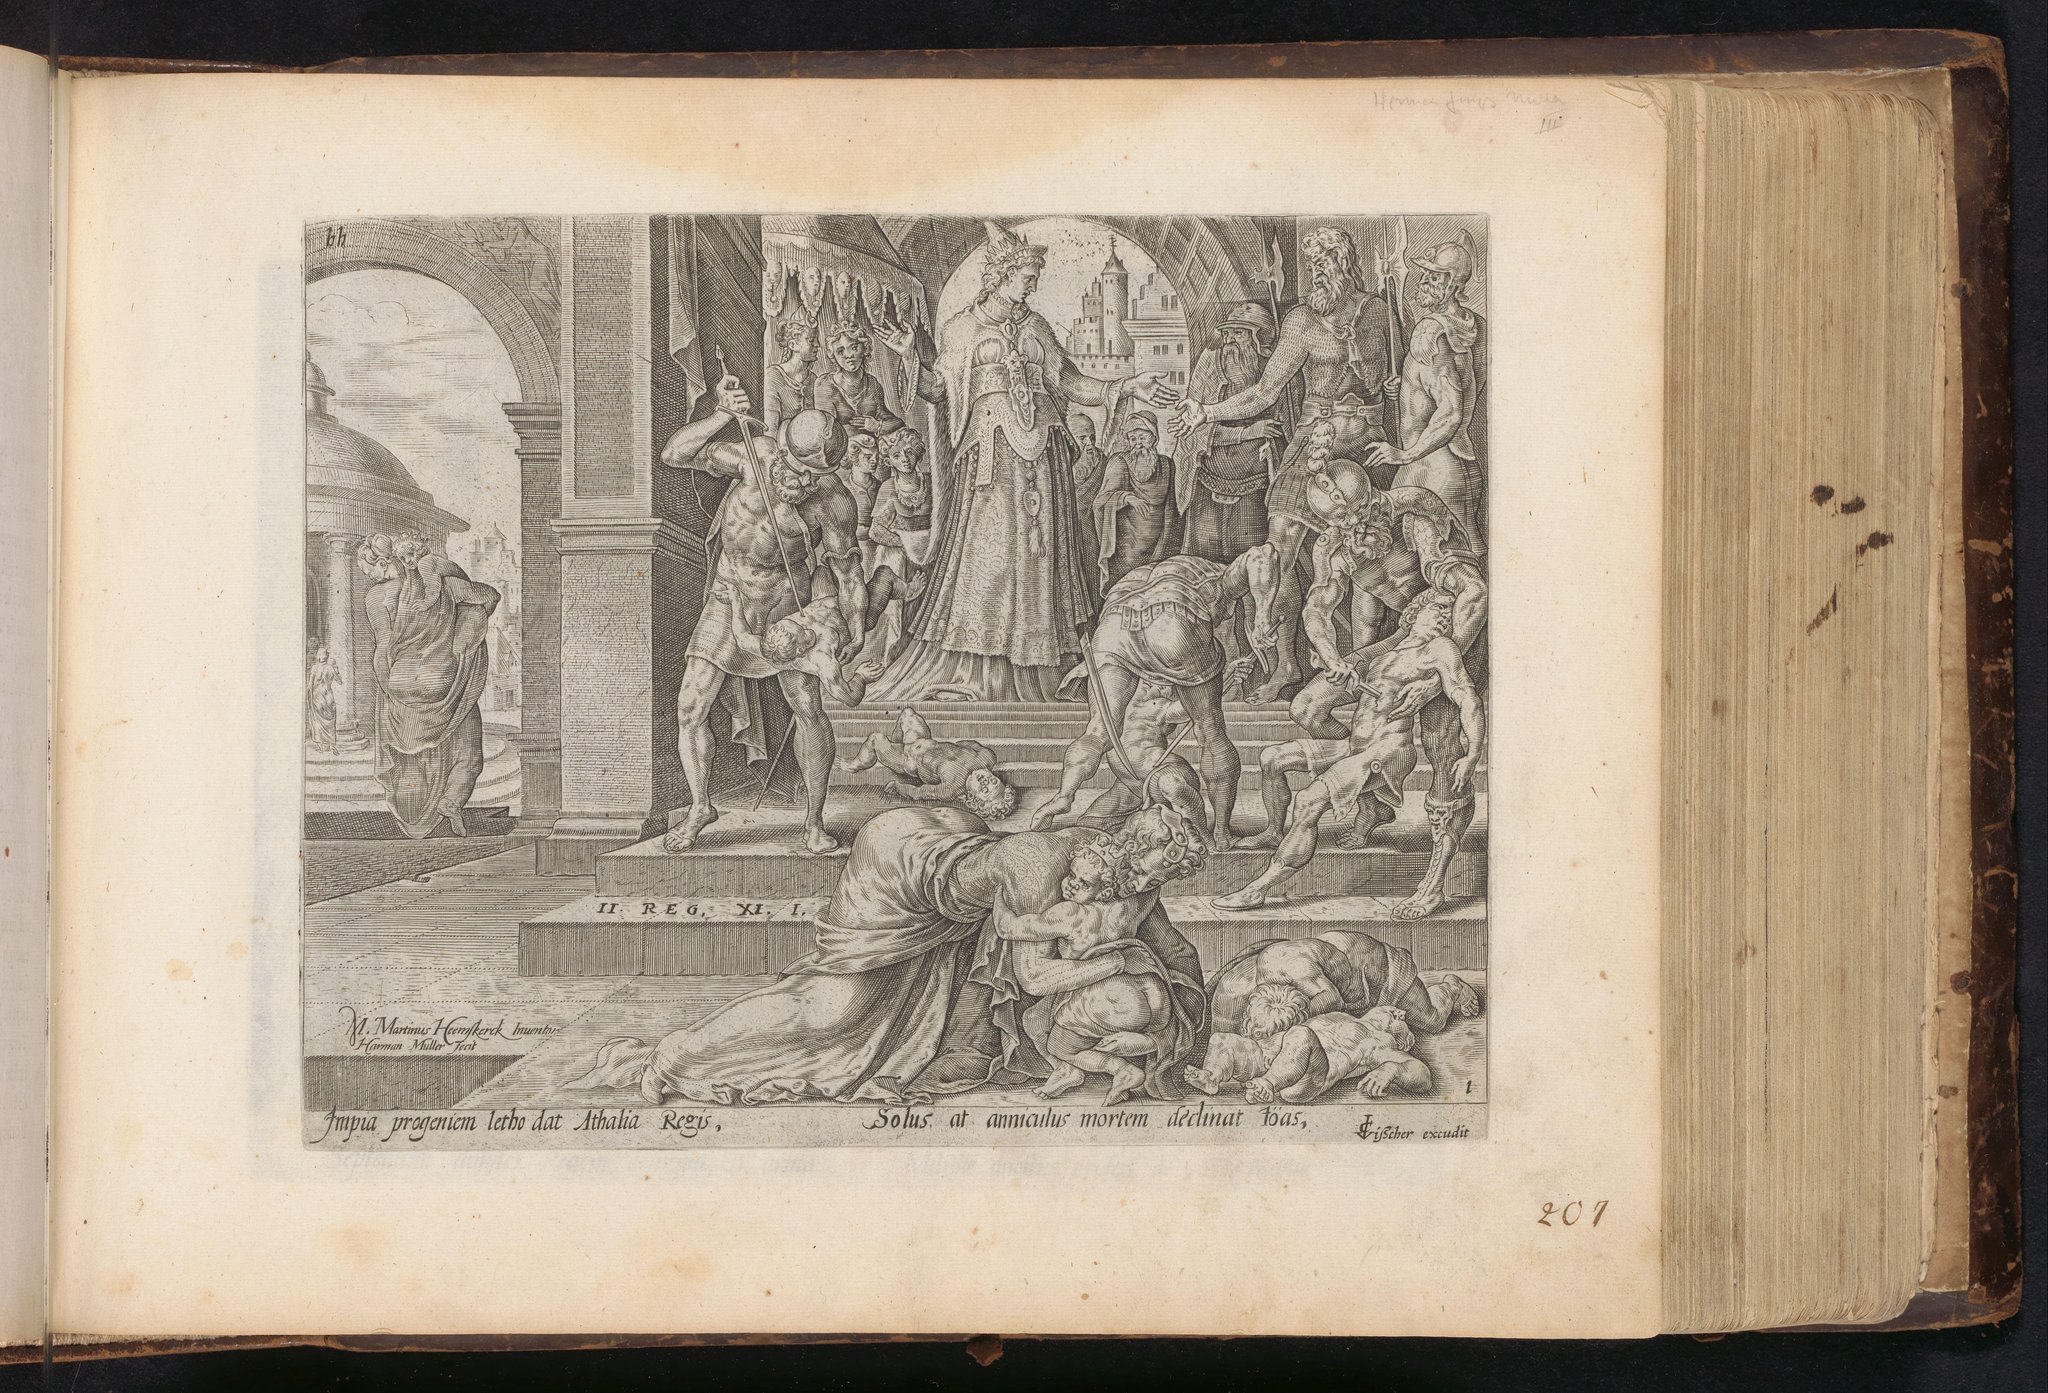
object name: album leaf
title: Gheschiedenissen in Juda, van Athalia en Joas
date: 1565-1569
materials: paper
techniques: engraving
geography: amsterdam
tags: joash is rescued by his aunt jehosheba, athaliah has all the members of the royal family killed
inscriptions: number: ‘207’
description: Atalja, die hoorde dat haar zoon koning Achazja was omgekomen, geeft opdracht om alle koningskinderen te doden, zodat zij koningin kan worden. Op de trap doden soldaten de kinderen. Links wordt Achazja's zoon Joas door zijn tante gered. Op de trap een verwijzing naar de Bijbeltekst in 2 Kon. 11:1. Onderaan in de marge een vers in het Latijn over de voorstelling. Deze prent maakt deel uit van een album.